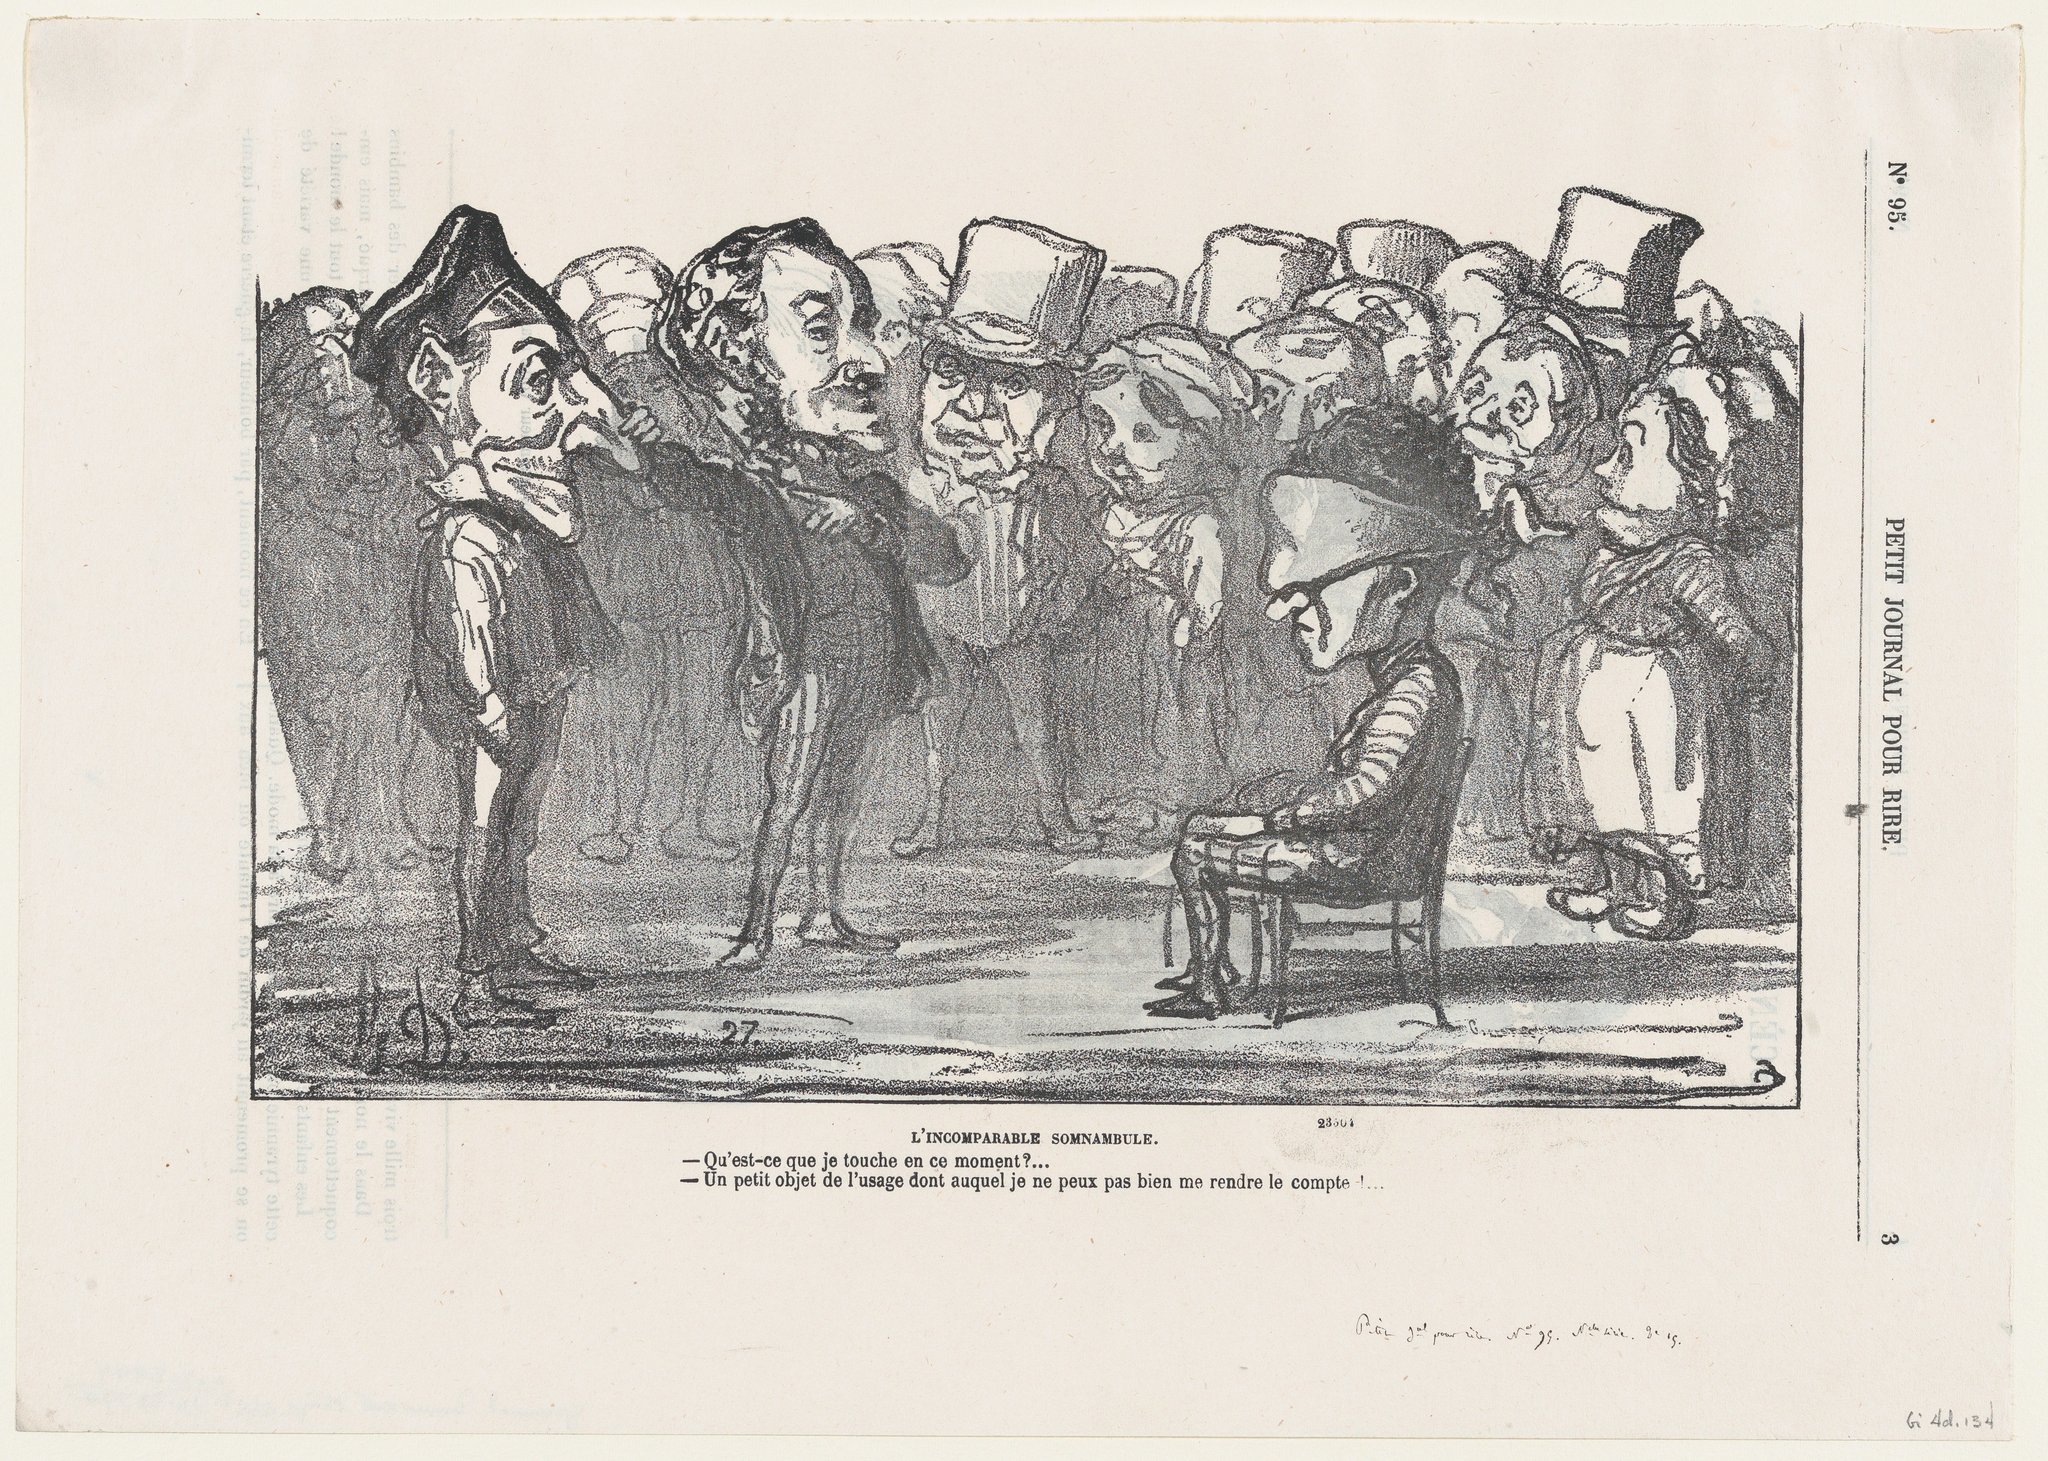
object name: print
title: The incomparable somnabulist," from 'Memories of the celebration at St. Cloud,' published in Le Petit Journal pour Rire, September 16, 1865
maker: honoré daumier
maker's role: artist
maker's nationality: french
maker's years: 1808-1879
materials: paper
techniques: lithograph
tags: satire,men,crowd